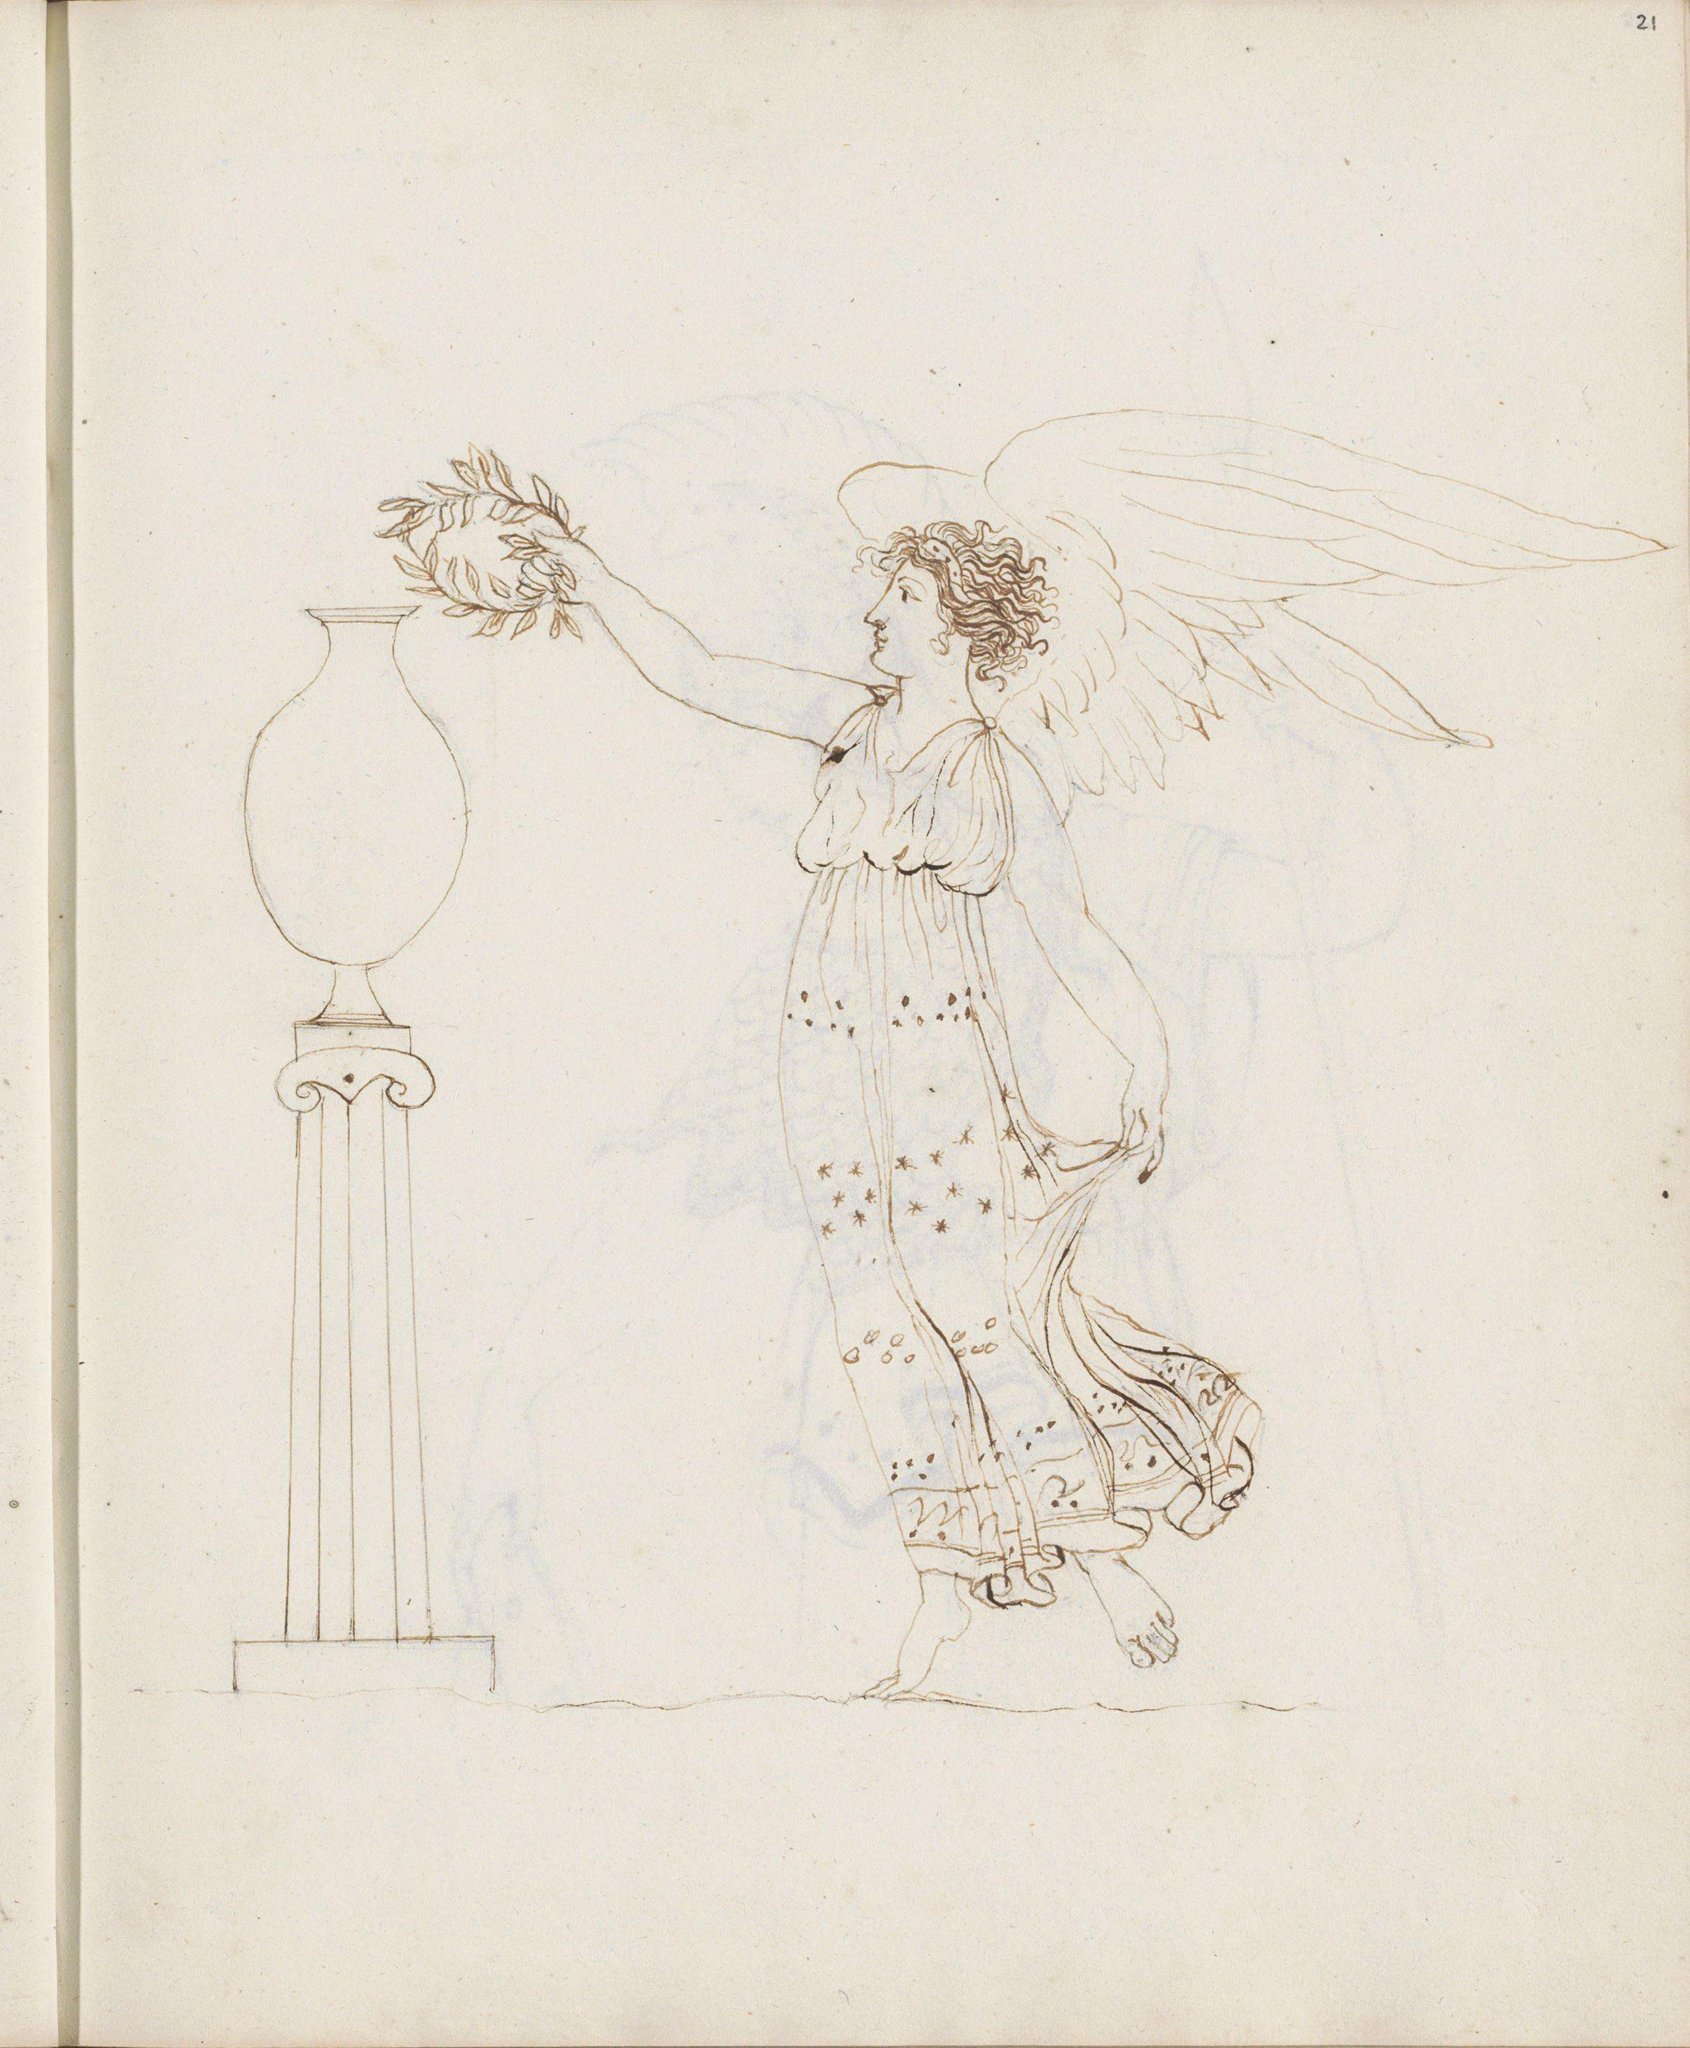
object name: sketchbook leaf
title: Fama die een olijfkrans plaatst op een monument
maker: jonkvrouw catharina kemper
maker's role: draughtsman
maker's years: 1801-1871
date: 1813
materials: ink, paper, pencil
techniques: pen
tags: monument, statue, fame; 'fama', 'fama buona', 'fama chiara' (ripa), angels, trees: olive-tree (+ branch, stick)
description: Het monument bestaat uit een vaas op een sokkel met Ionisch kapiteel. Blad 21 recto uit een schetsboek met 91 bladen.